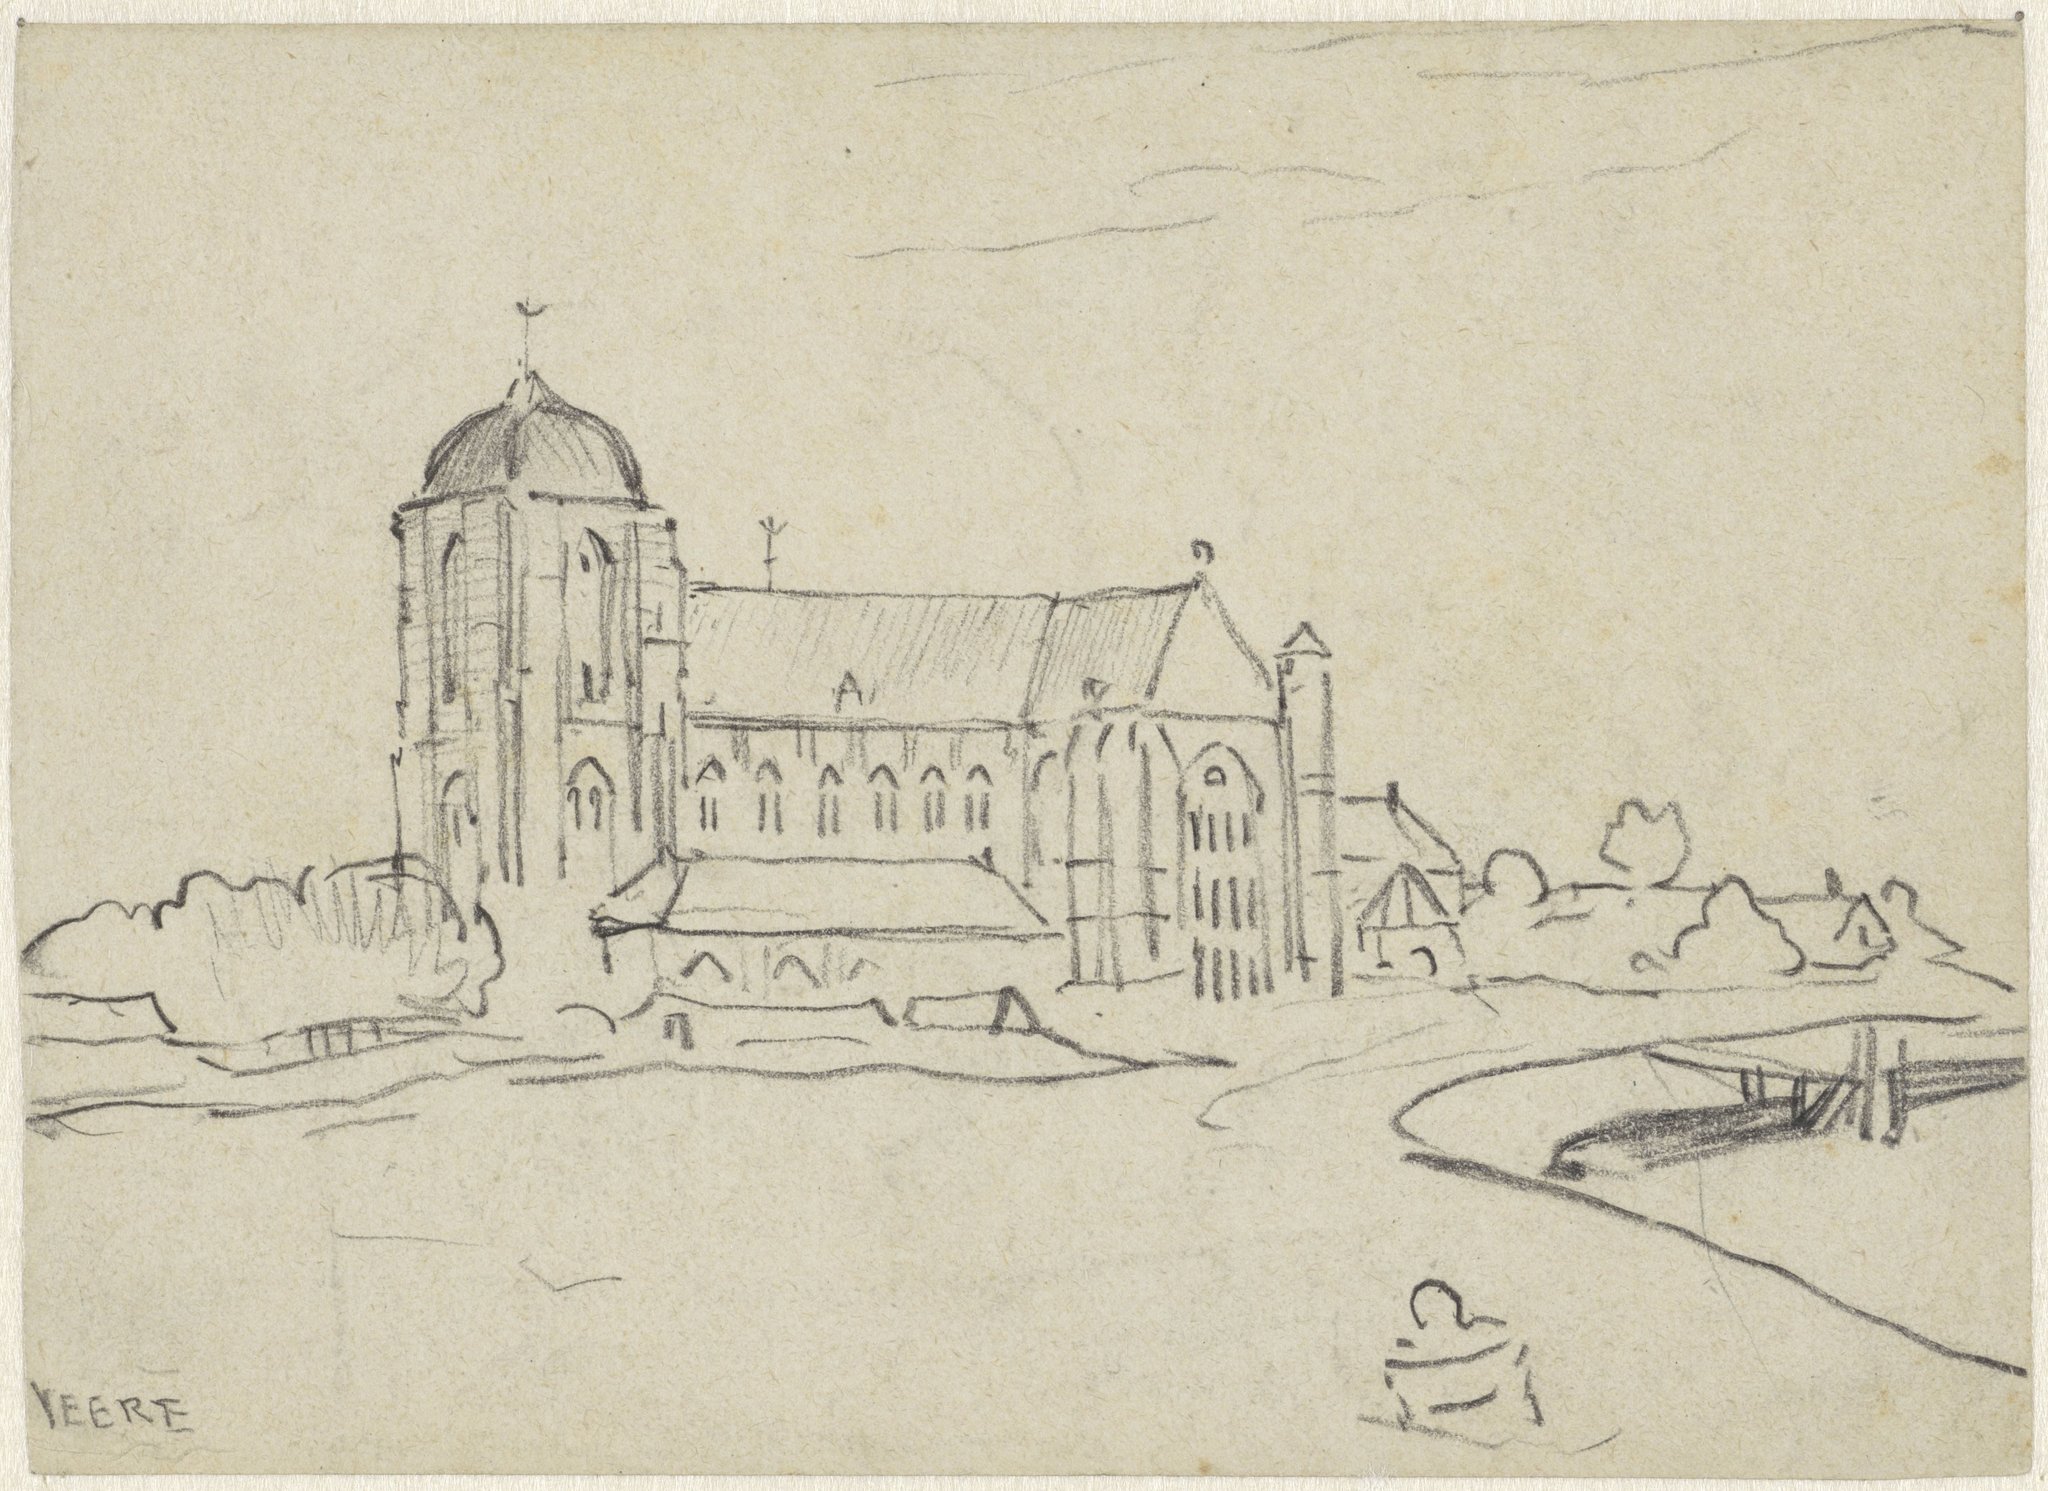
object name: drawing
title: Kerk te Veere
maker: adolf le comte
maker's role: draughtsman, painter, print maker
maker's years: 1850-1921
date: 1860-1921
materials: chalk, paper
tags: church (exterior)